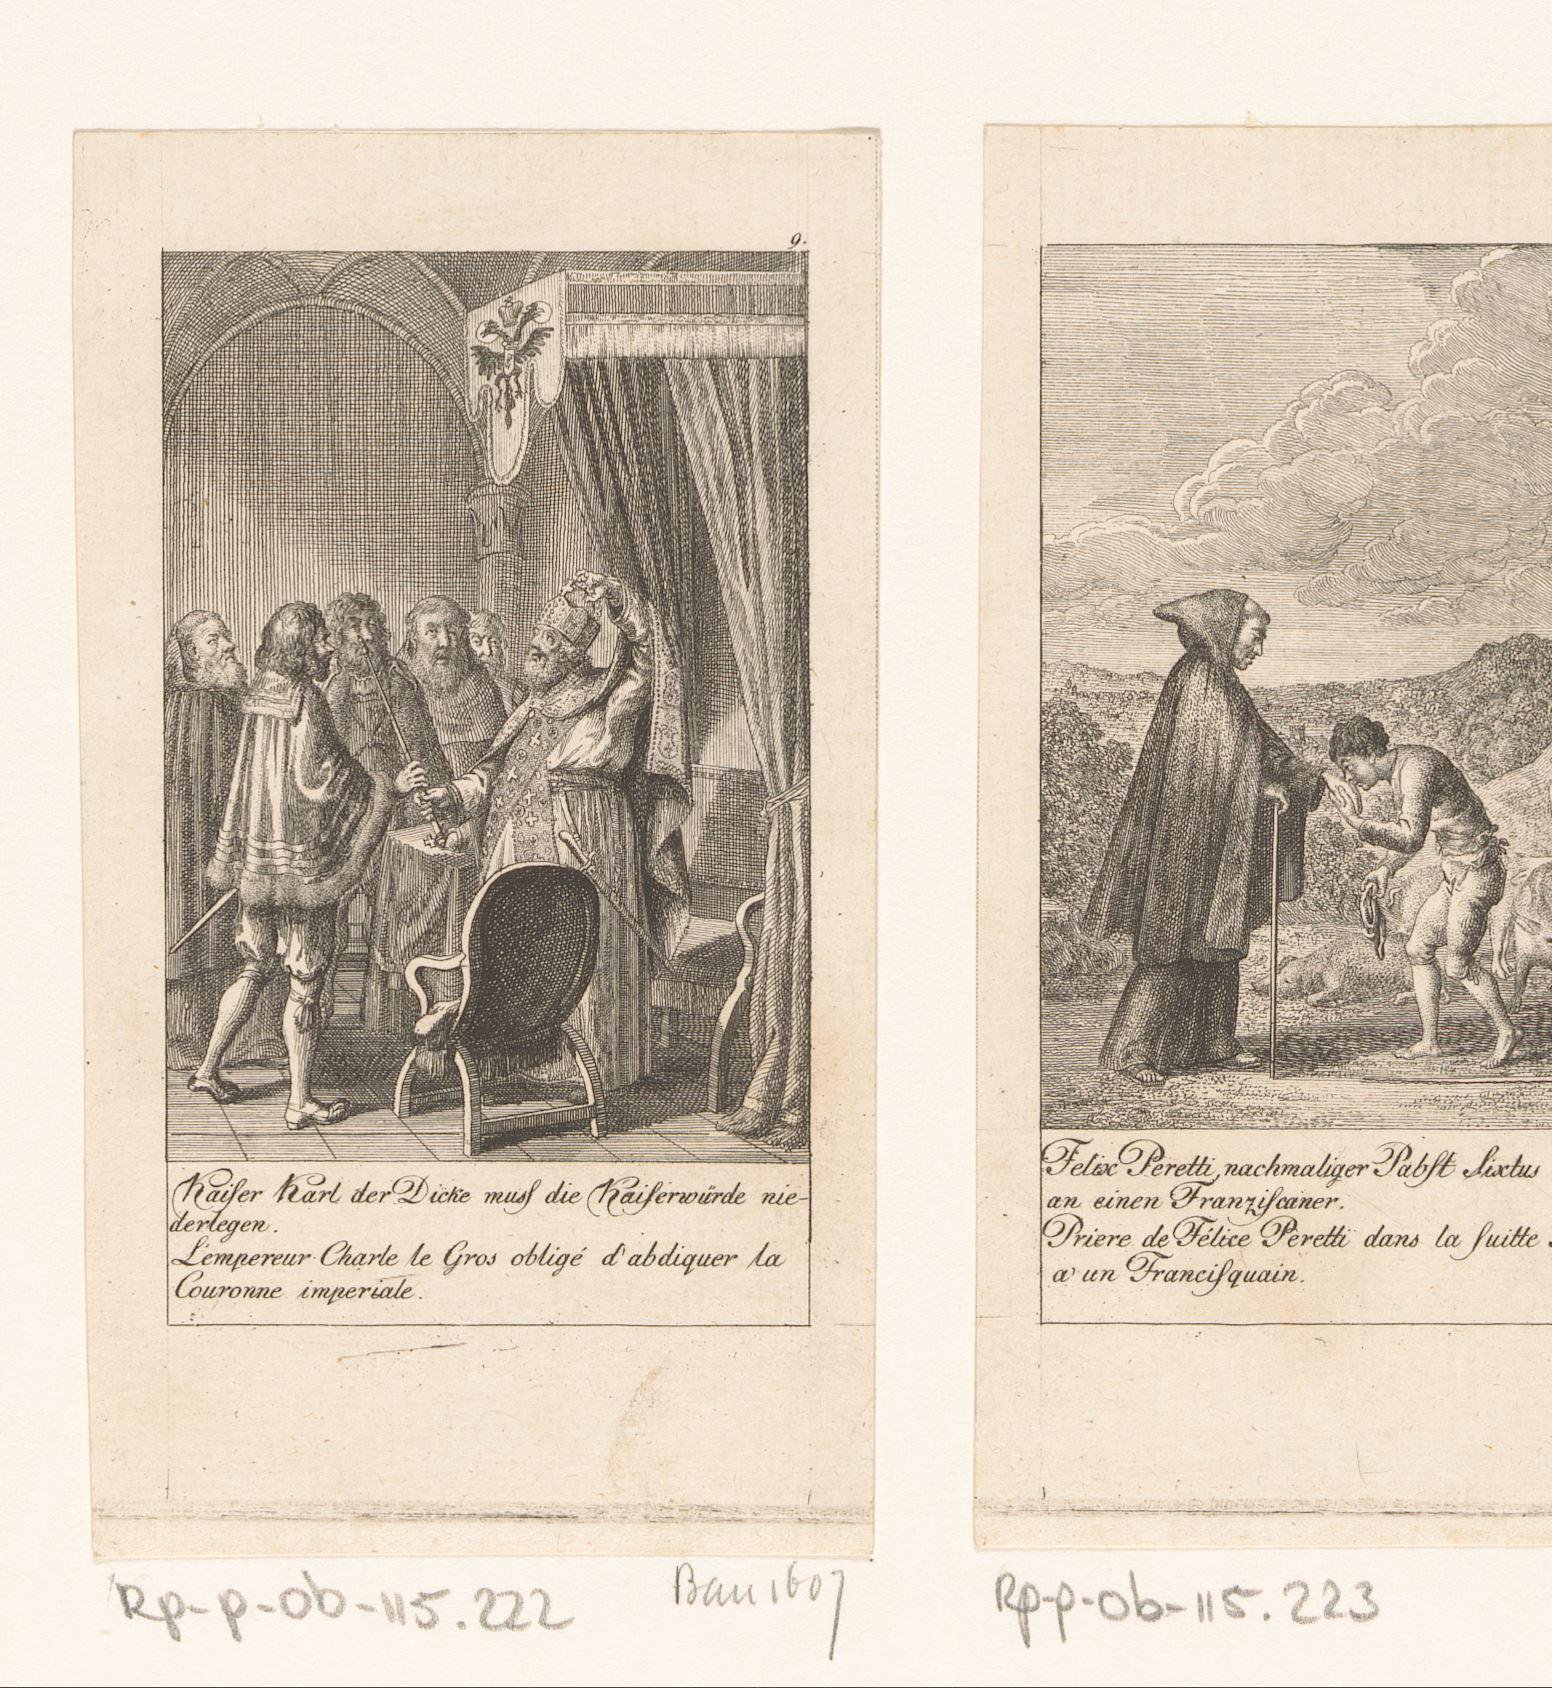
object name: print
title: Karel de Dikke wordt afgezet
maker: daniel nikolaus chodowiecki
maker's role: draughtsman, print maker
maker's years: 1726-1801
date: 1792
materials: paper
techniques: etching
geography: berlin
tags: double-headed eagle, crown (symbol of sovereignty), history, abdication (of a ruler)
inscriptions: collector's mark: Lugt 2228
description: Latere staat gebruikt voor: Almanac de Gotha pour l'anneé 1793. Gotha: C. W. Ettinger, [1792].